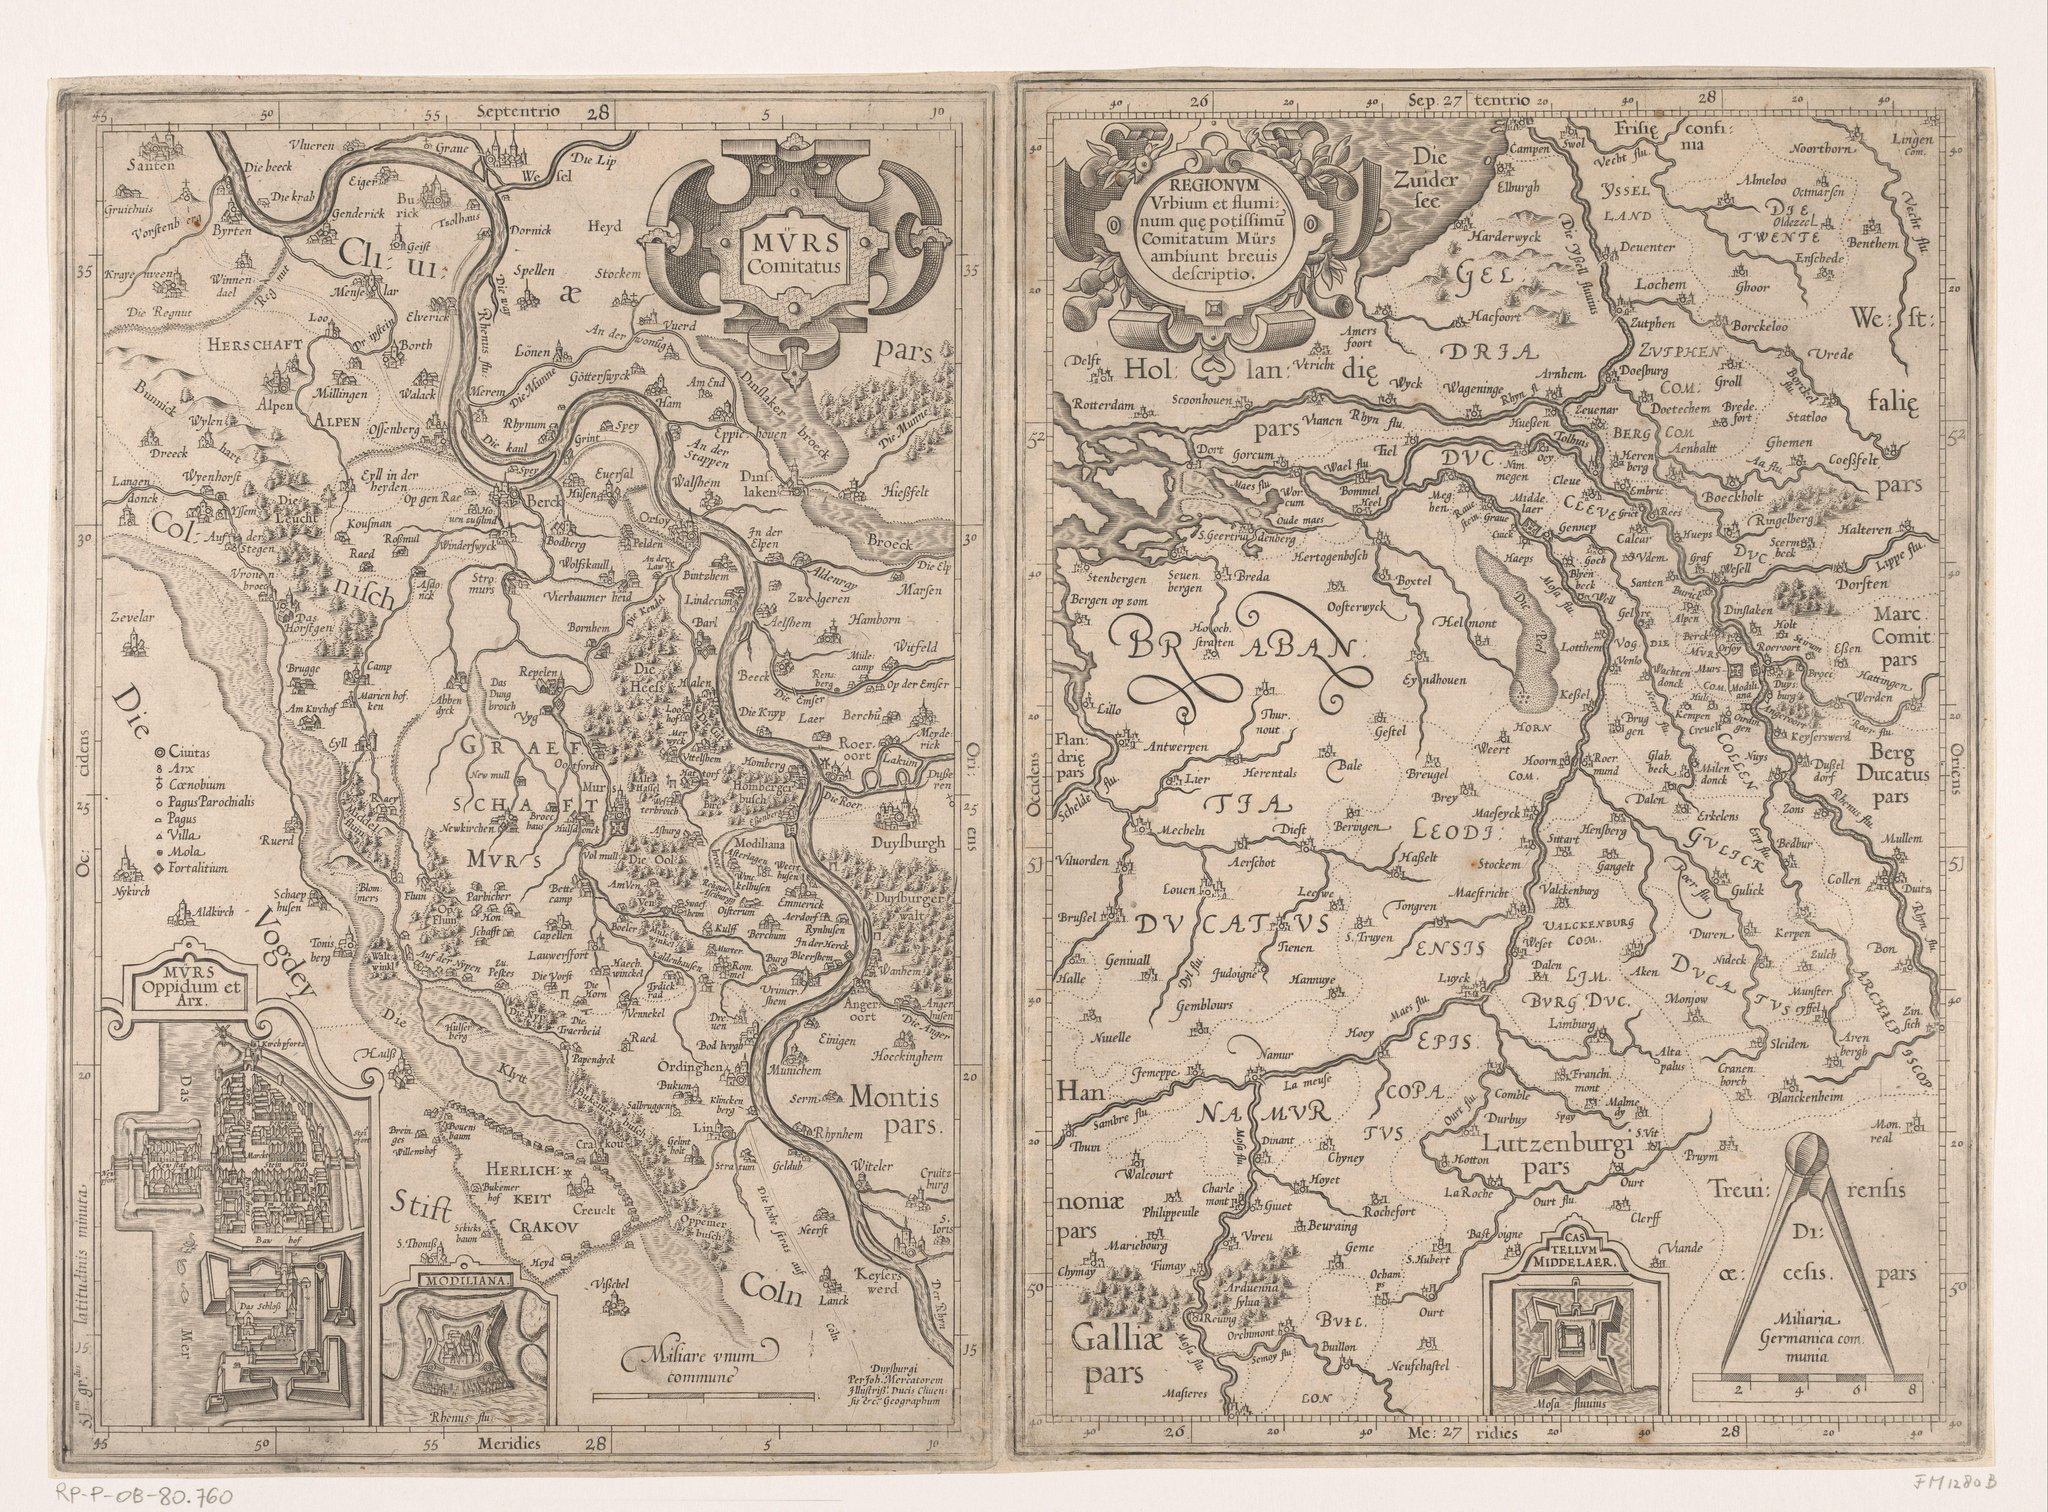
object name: print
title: Kaart van het graafschap Moers en van het Rijnland, 1610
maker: joannes mercator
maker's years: 1562-1595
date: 1591-1595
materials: paper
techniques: engraving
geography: duisburg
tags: maps of separate countries or regions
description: Kaarten van het graafschap Moers en van de ligging van het graafschap in het Rijnland. Twee afzonderlijke kaarten op één blad gedrukt. Op de kaart van Moers een inzet met een plattegrond van de stad Moers, op de kaart van het Rijnland een inzet met een plattegrond van het kasteel Middelaar.